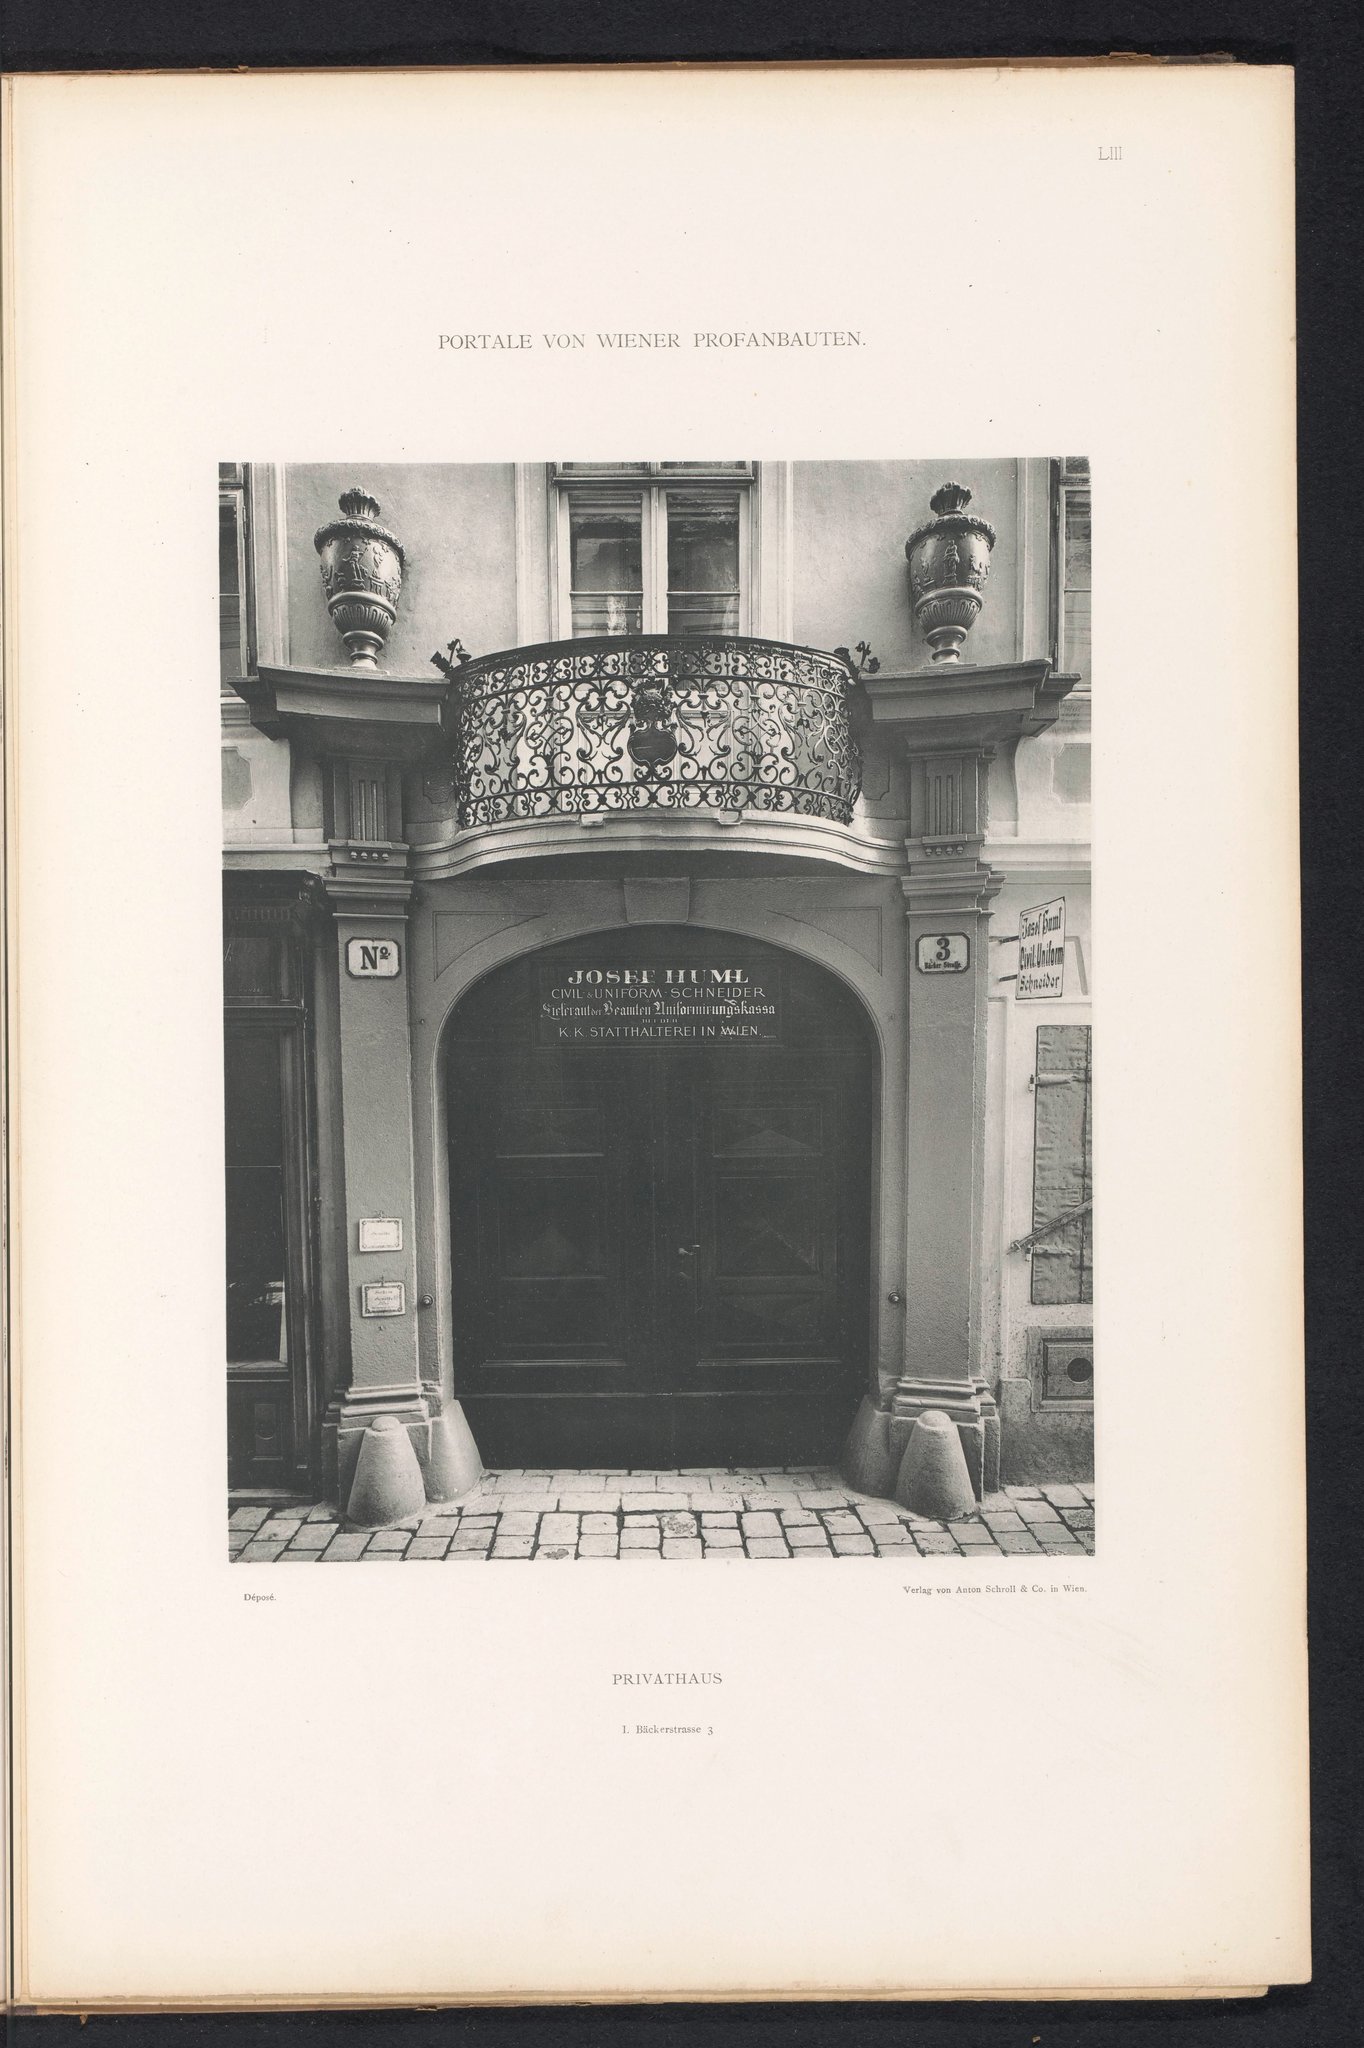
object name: page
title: Toegangsportaal van een woning aan Bäckerstrasse 3 te Wenen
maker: Anonymous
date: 1884-1894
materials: paper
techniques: photograph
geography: vienna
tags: gate, entrance, façade (of house or building)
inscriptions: inscription: ‘I. Bäckerstrasse 3’, number: ‘LIII’